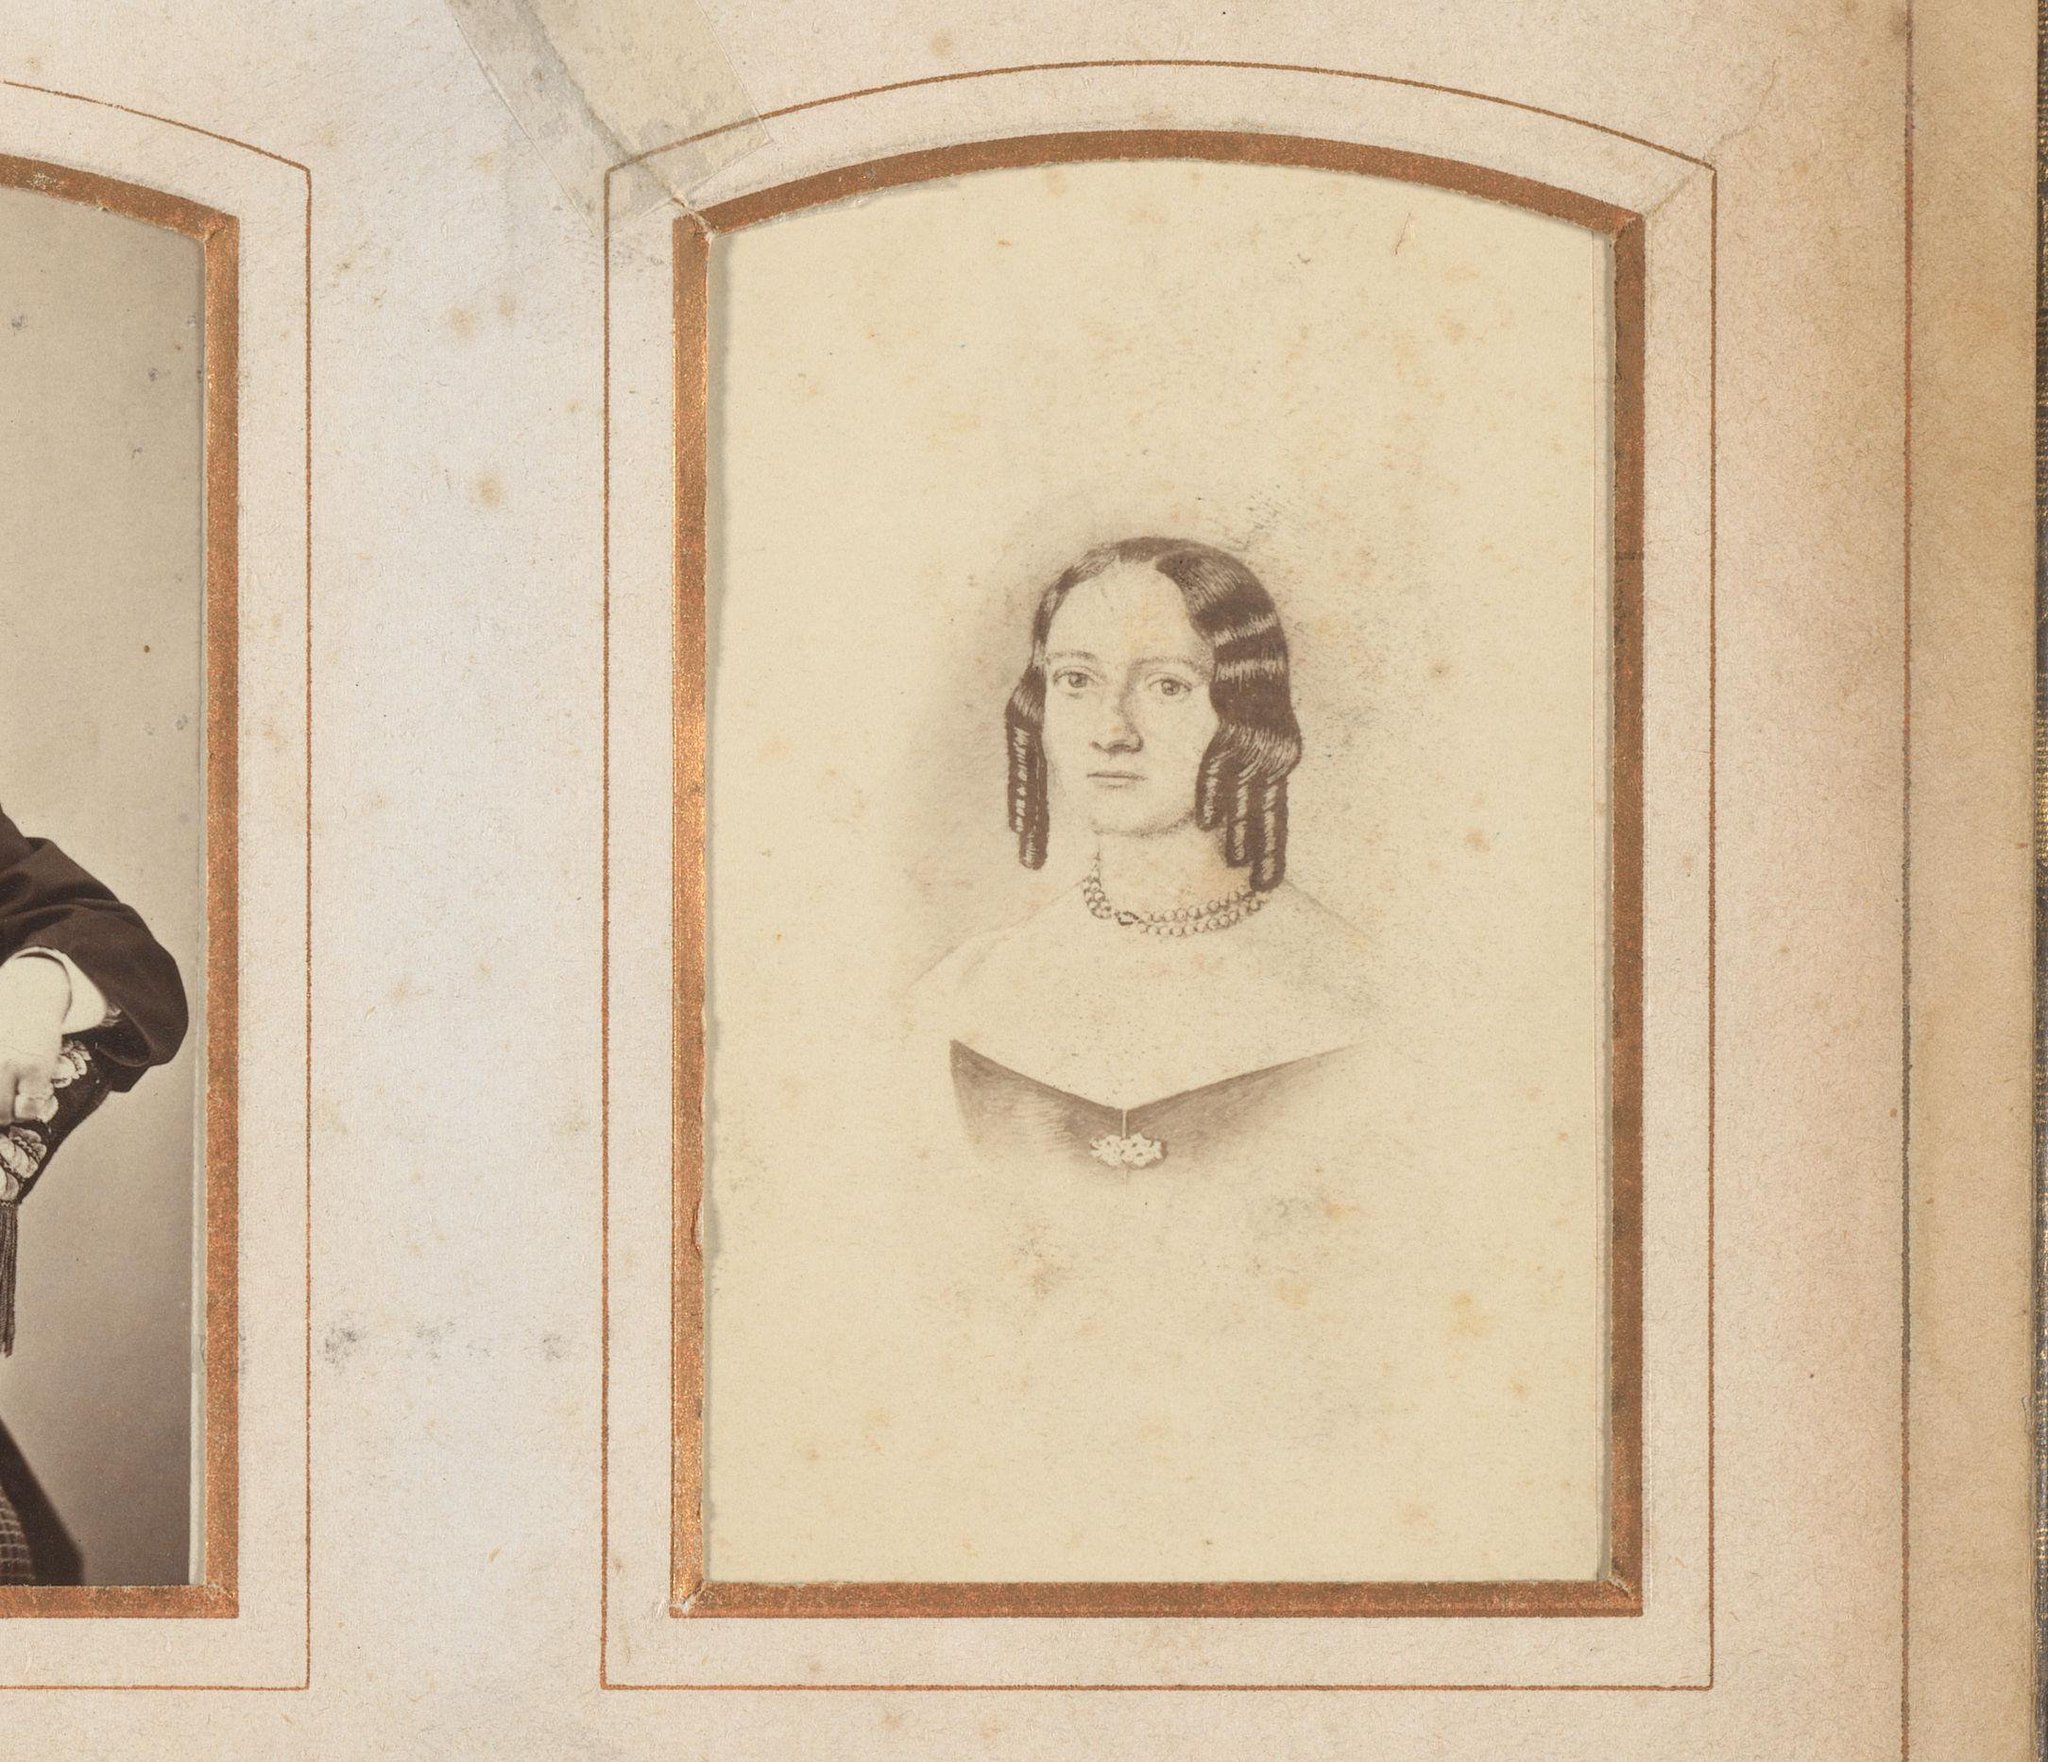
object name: photograph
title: Fotoreproductie van een getekend portret van een jonge vrouw met pijpenkrullen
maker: axel wilhelm åkerlind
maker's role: fotograaf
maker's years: 1827-1906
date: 1868-1875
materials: cardboard, paper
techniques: albumen print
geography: stockholm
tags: adolescent, young woman, maiden, historical persons - bb - woman, hairdress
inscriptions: inscription: ‘A. W. Åkerlind, No. 5, Norra Smedjegatan.’